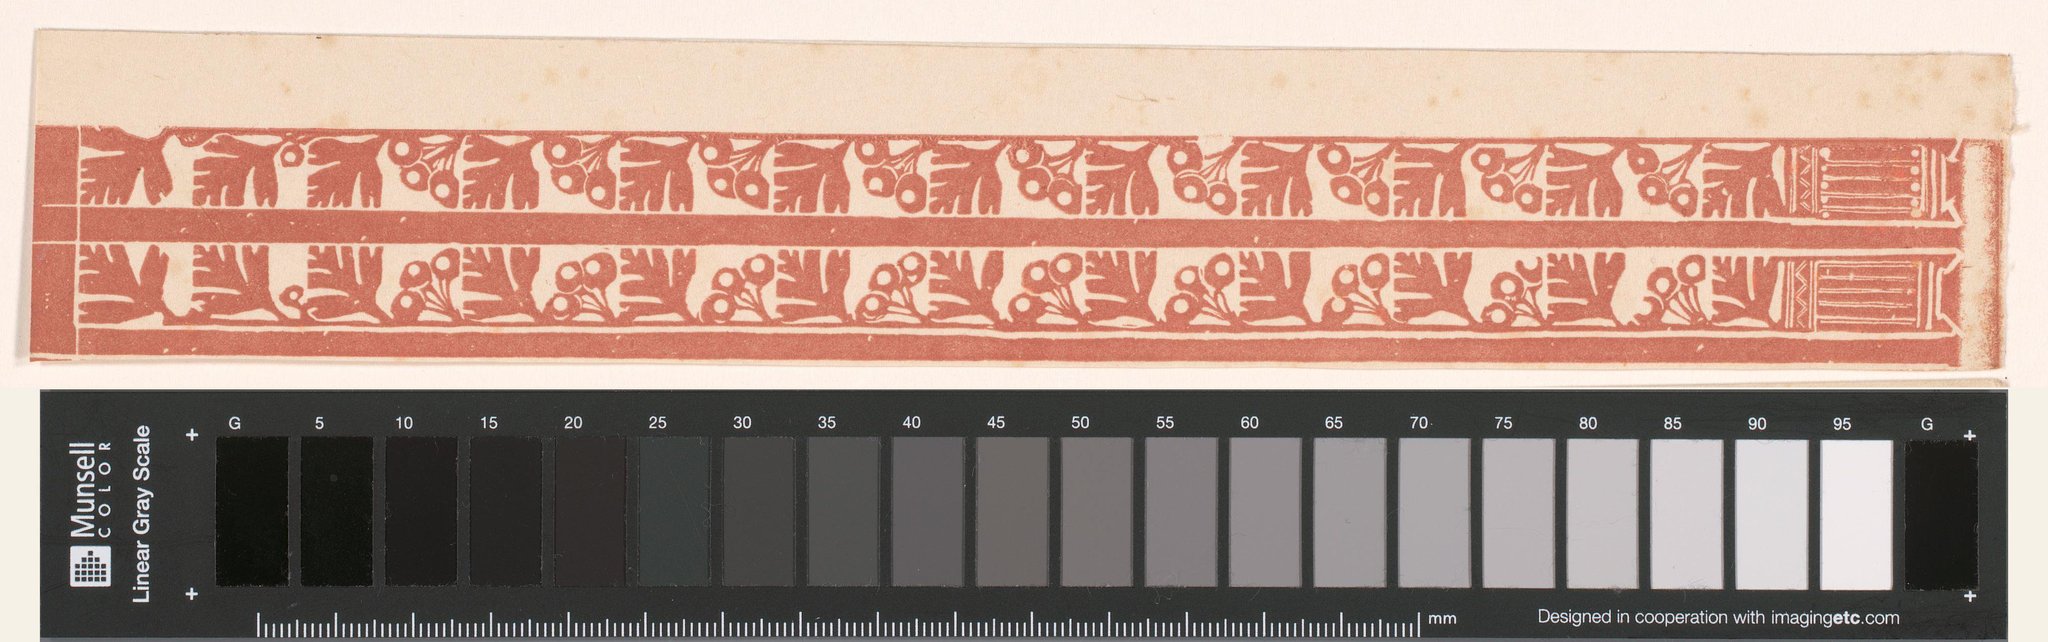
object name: print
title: Ornament met planten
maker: bernard willem wierink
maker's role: draughtsman, print maker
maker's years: 1856-1939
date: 1910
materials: paper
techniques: relief print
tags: ornaments ~ art, fable of reynard the fox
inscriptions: collector's mark: Lugt 2228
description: Ontwerp voor: Streuvels, Stijn (Frank Lateur). Reinaert de Vos naar verschillende uitgaven van het middeleeuwsche epos. Amsterdam: L.J. Veen, 1910. Deze prent is vermoedelijk een plaatsnede, ook al wordt in de literatuur veelal gesproken over een houtsnede. Voor zover Wierink zijn prenten in hoogdruk zelf nader heeft omschreven, heeft hij altijd de term 'plaatsnede' gebruikt.